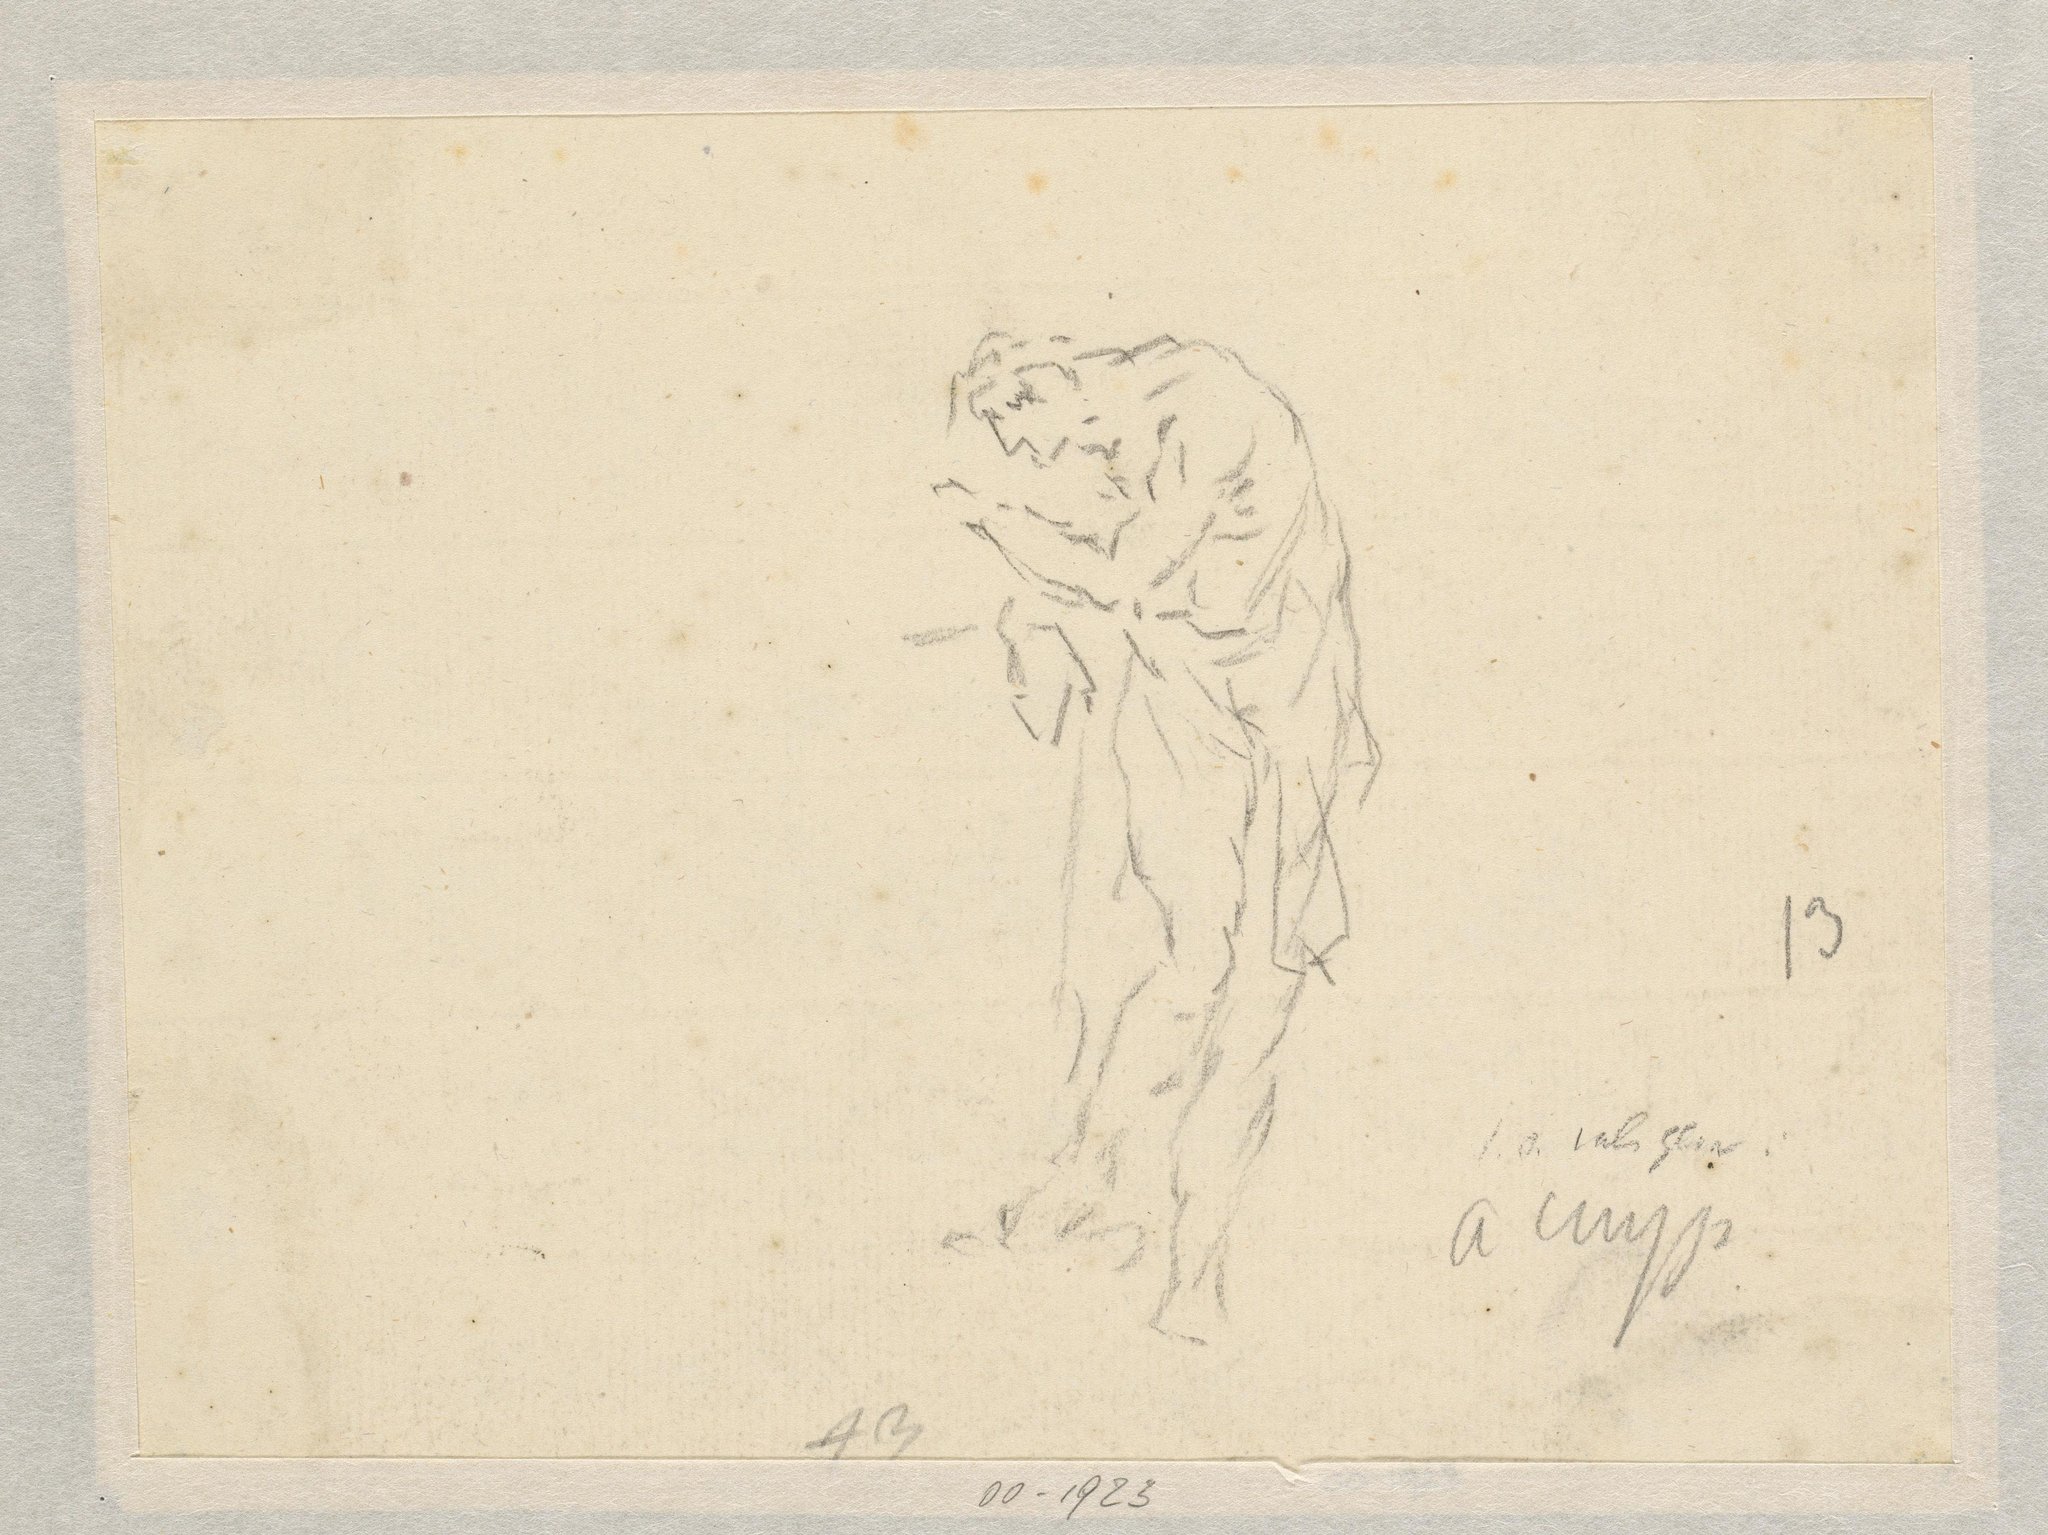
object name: drawing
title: Schets van een staande man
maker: Anonymous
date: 1700-1800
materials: chalk, paper